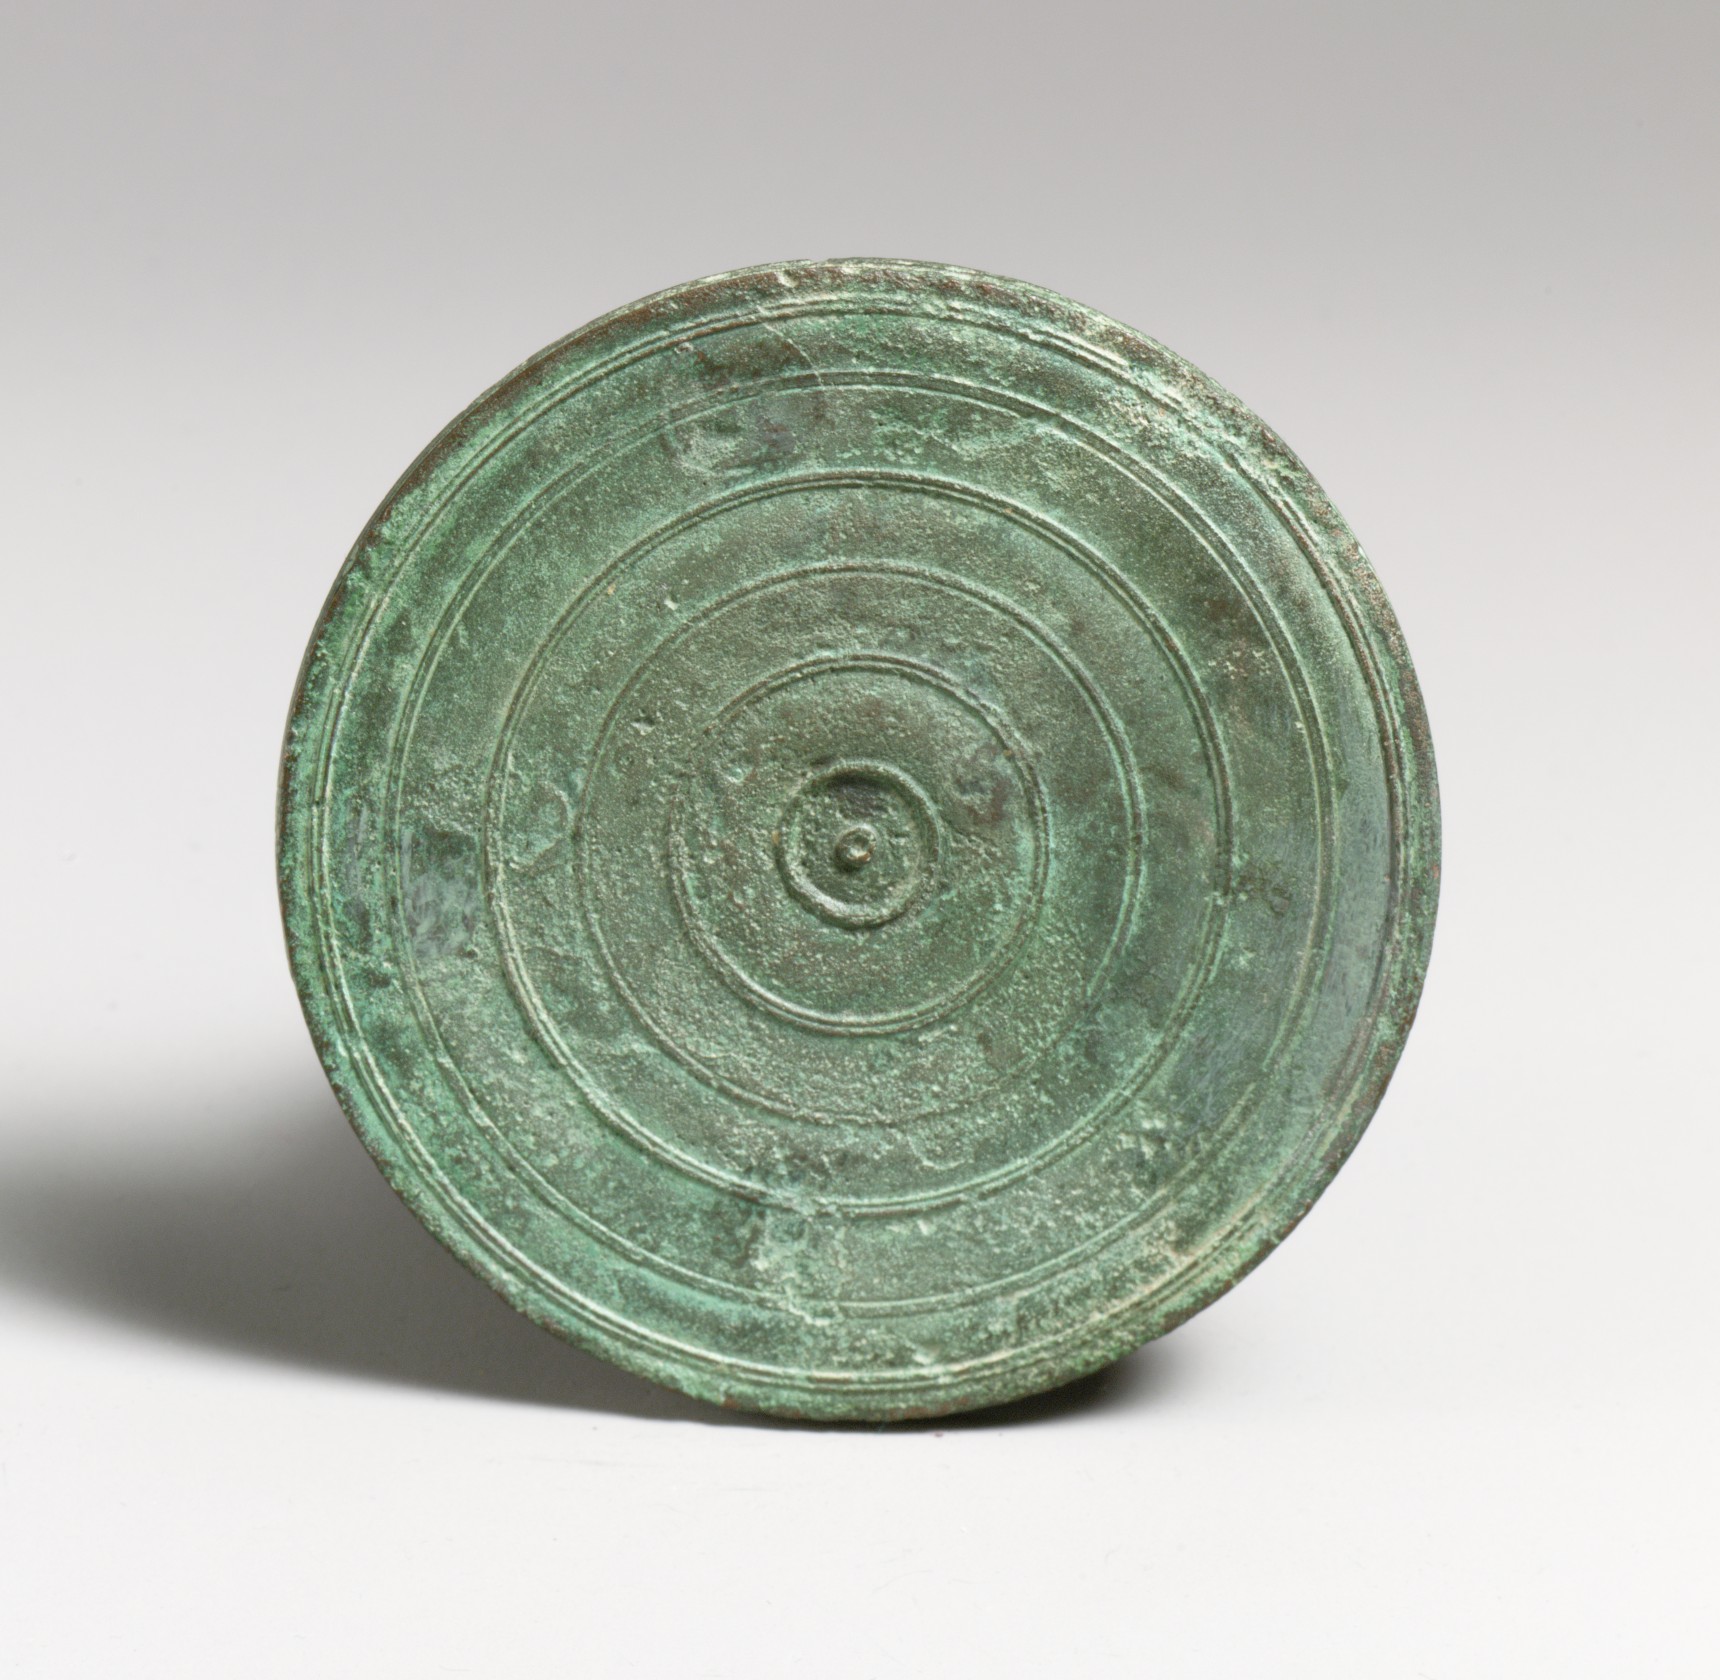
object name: mirror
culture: greek, cypriot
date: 7000-30 BCE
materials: bronze